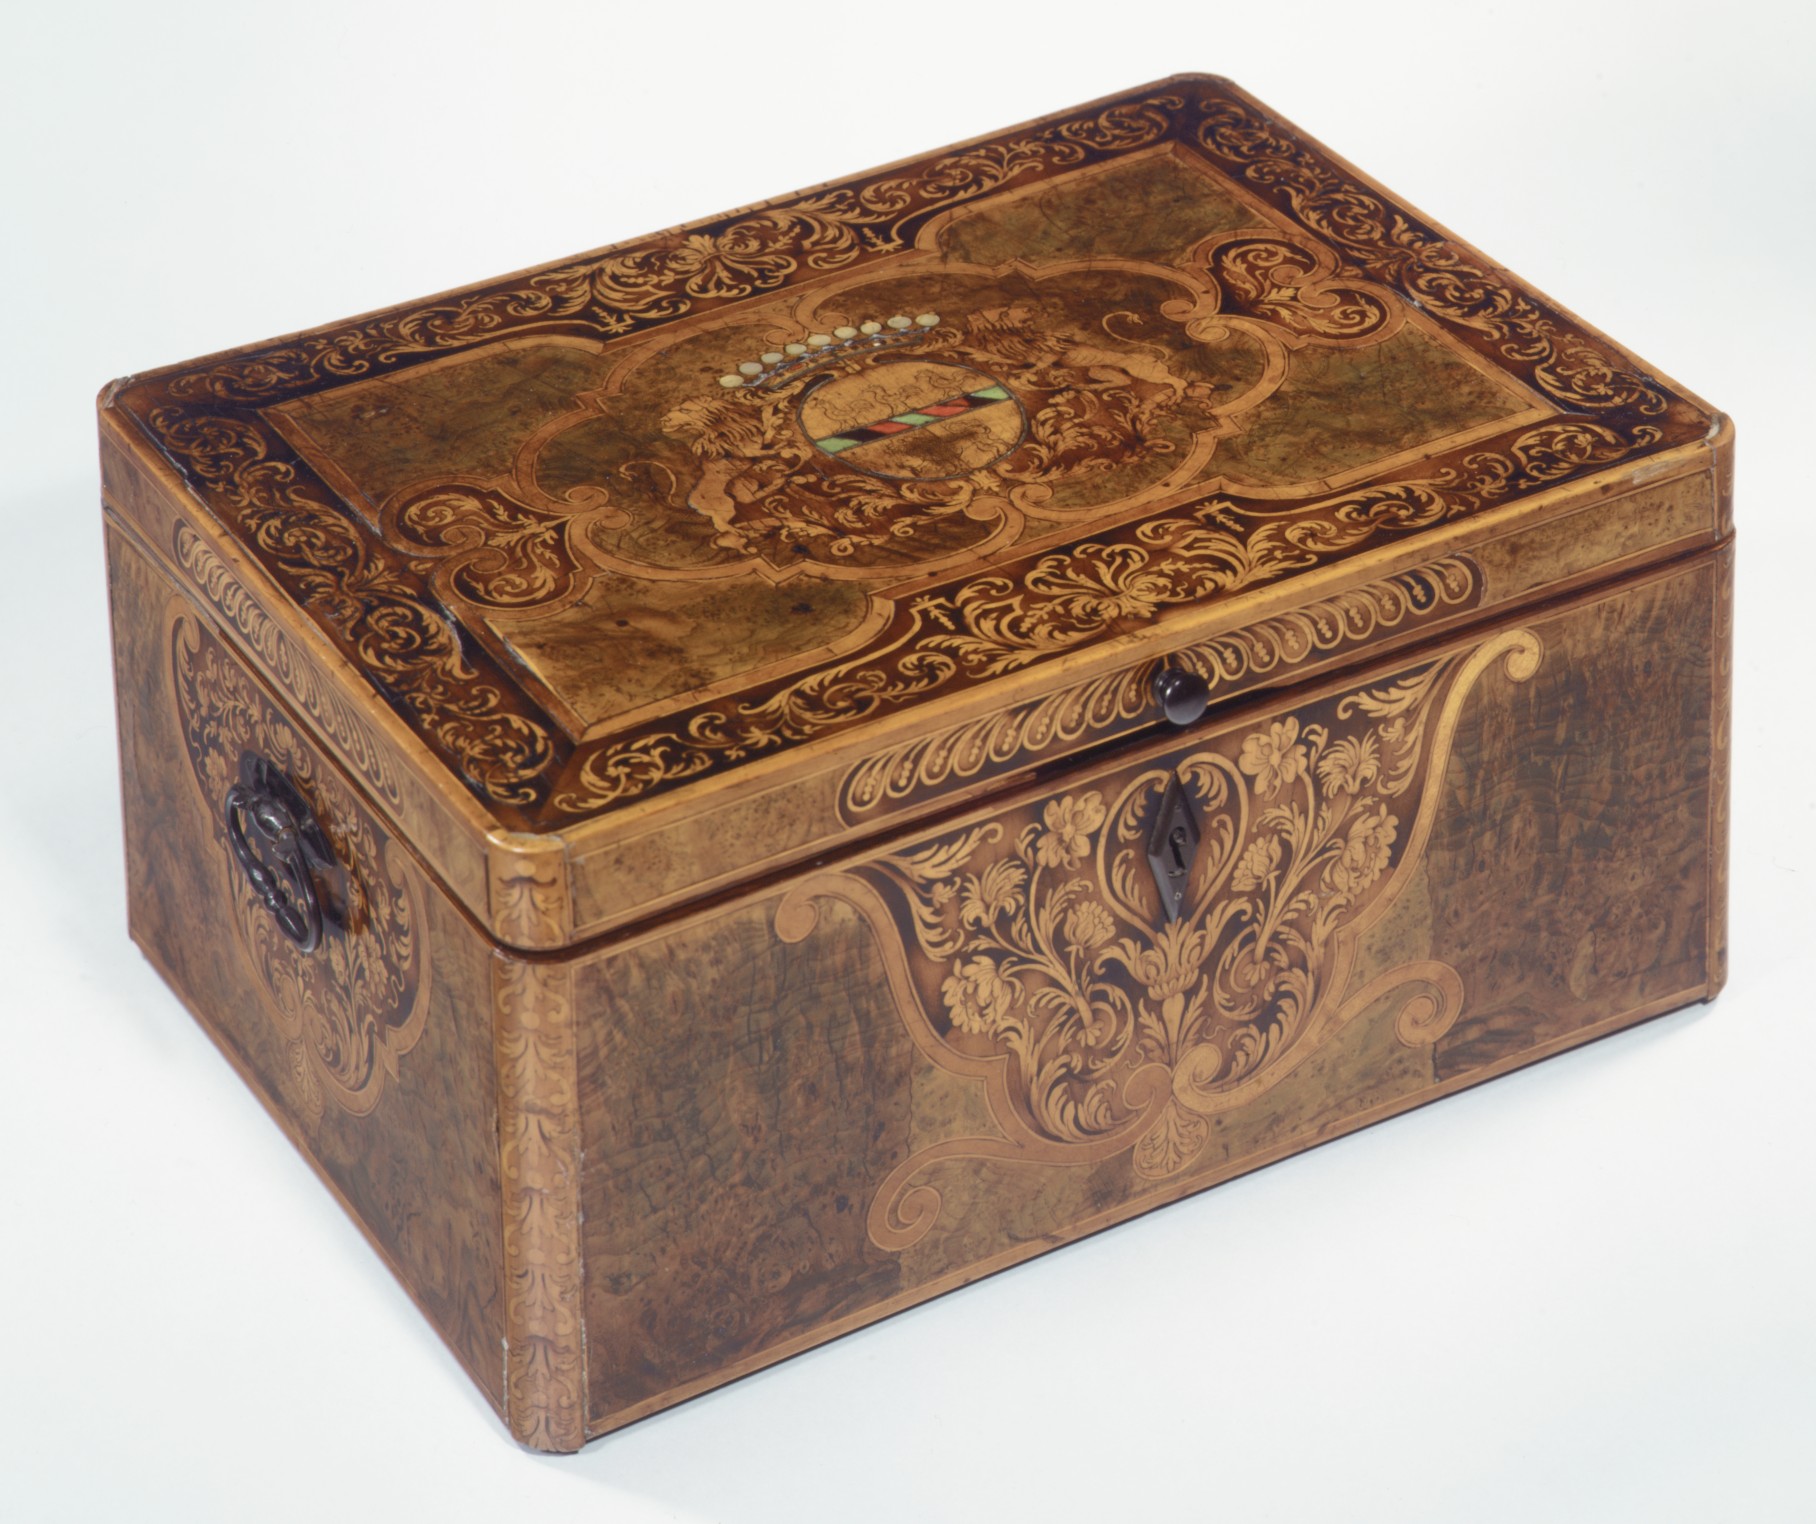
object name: box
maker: pierre hache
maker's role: maker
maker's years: 1705-1776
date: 1740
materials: ivory, mother of pearl, wood, iron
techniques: veneering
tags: flowers,coat of arms